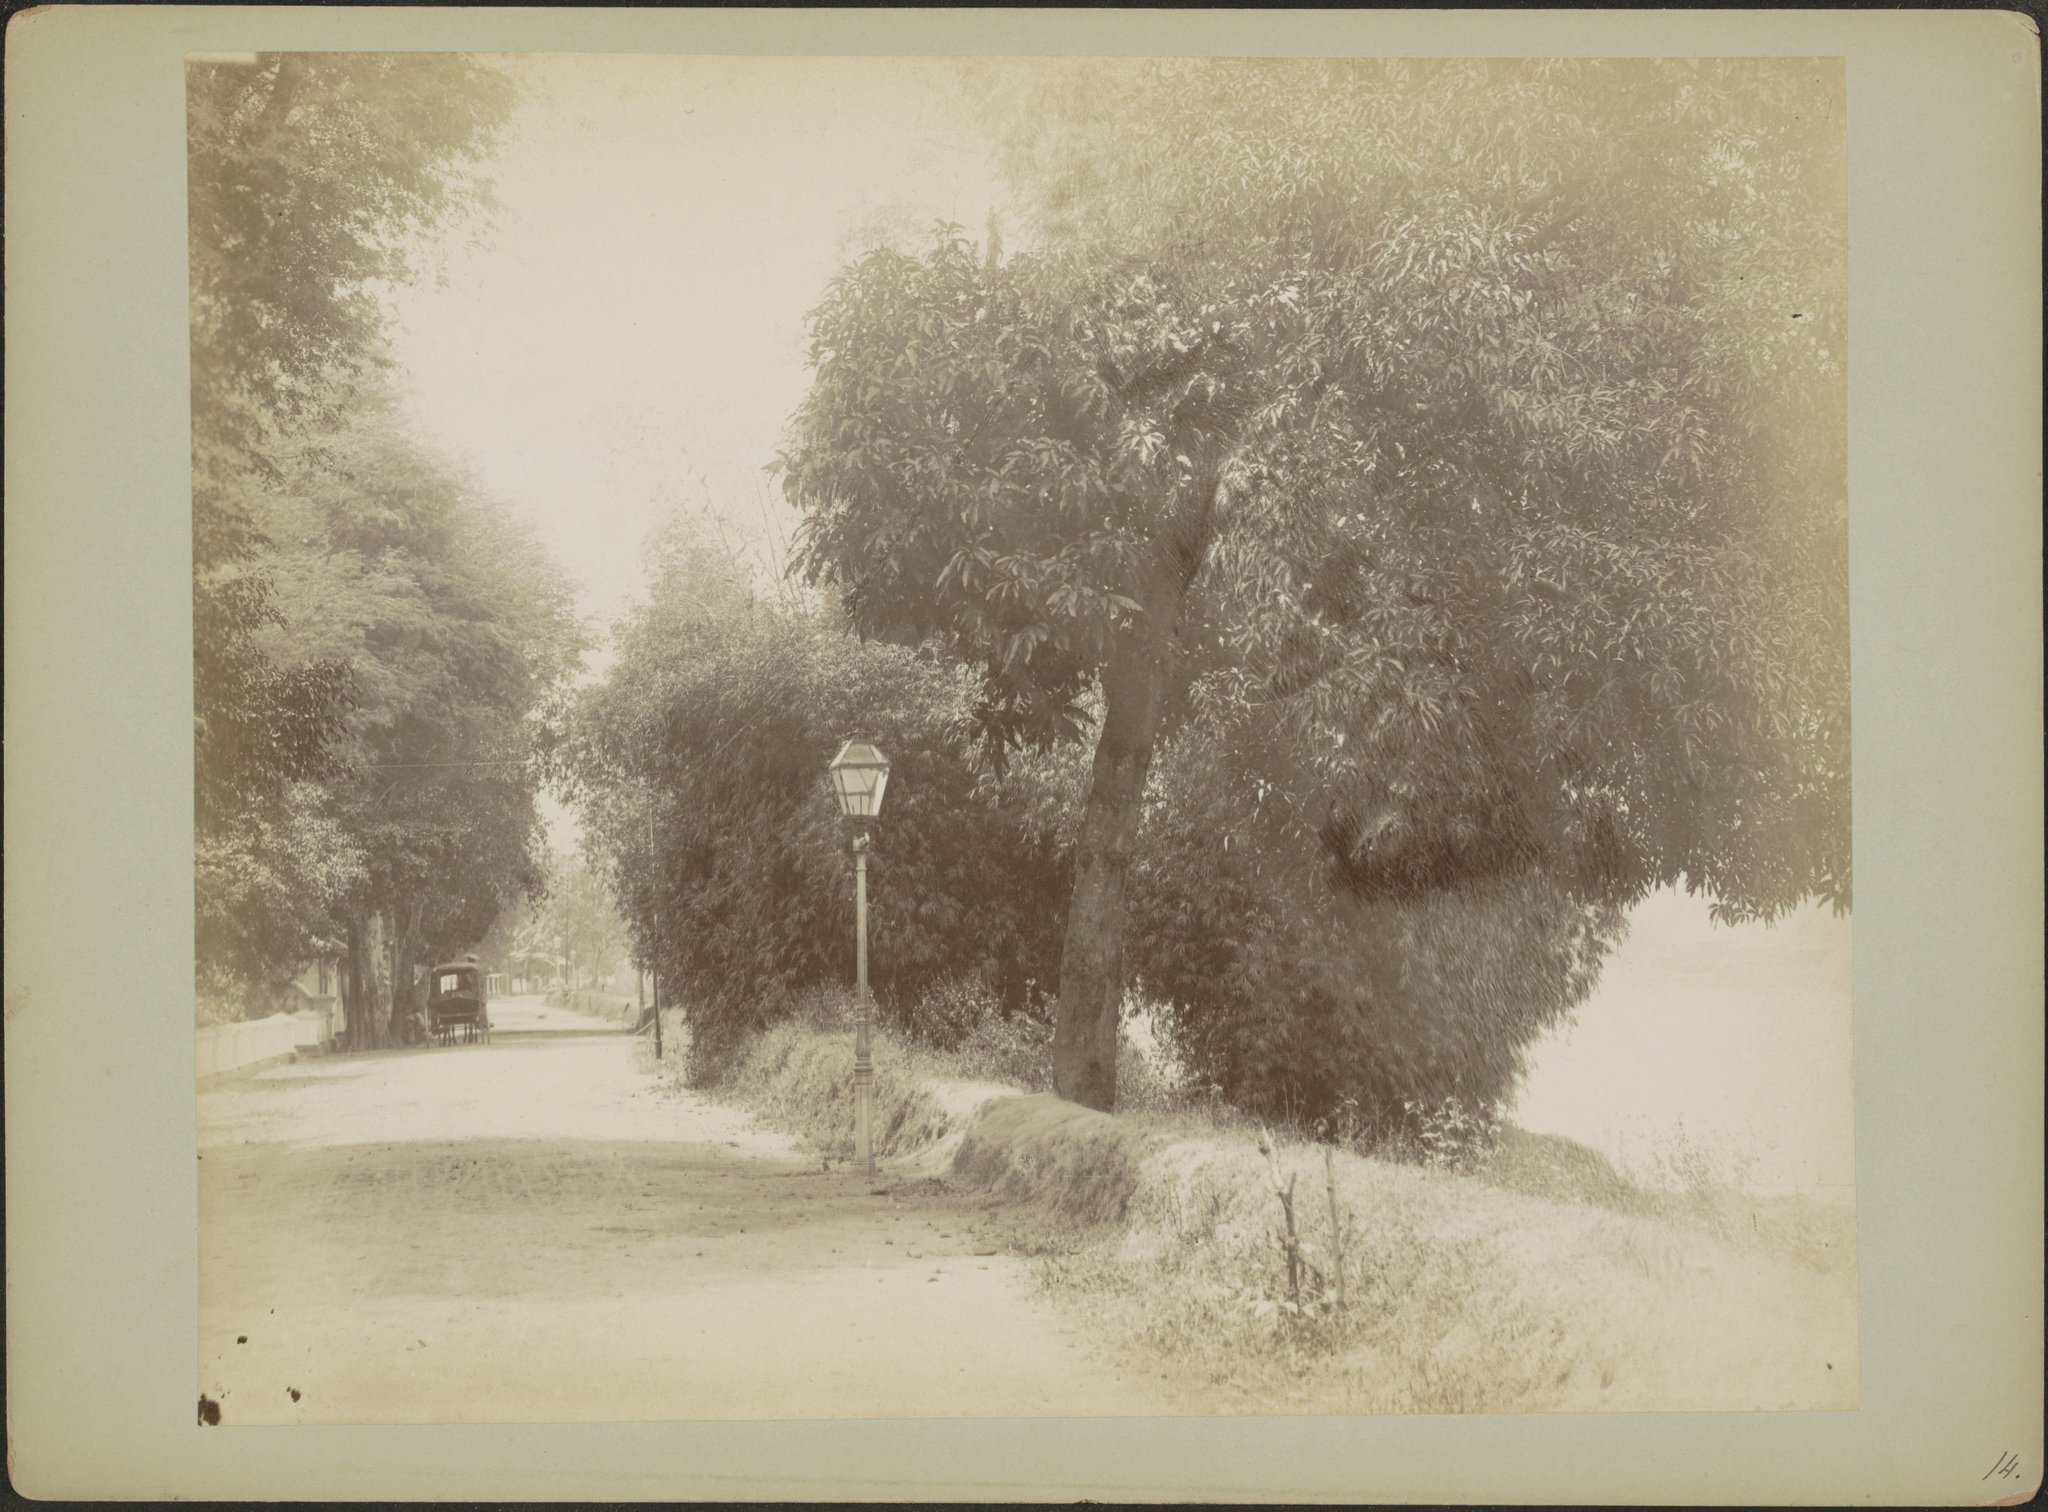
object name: photograph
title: Weg (Gayoon) met een rijtuig en een lantaarnpaal langs een water in Soerabaja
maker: Anonymous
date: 1870-1910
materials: cardboard, paper, photographic support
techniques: albumen print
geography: surabaya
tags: two-wheeled, animal-drawn vehicle, road, path, lantern, surabaya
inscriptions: inscription: ‘Gayoon. Soerabaia.’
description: Onderdeel van Reisalbum met foto's van bezienswaardigheden in Marseille, Port Said, Aden, Bombay, Colombo, Singapore en Nederlands-Indië.